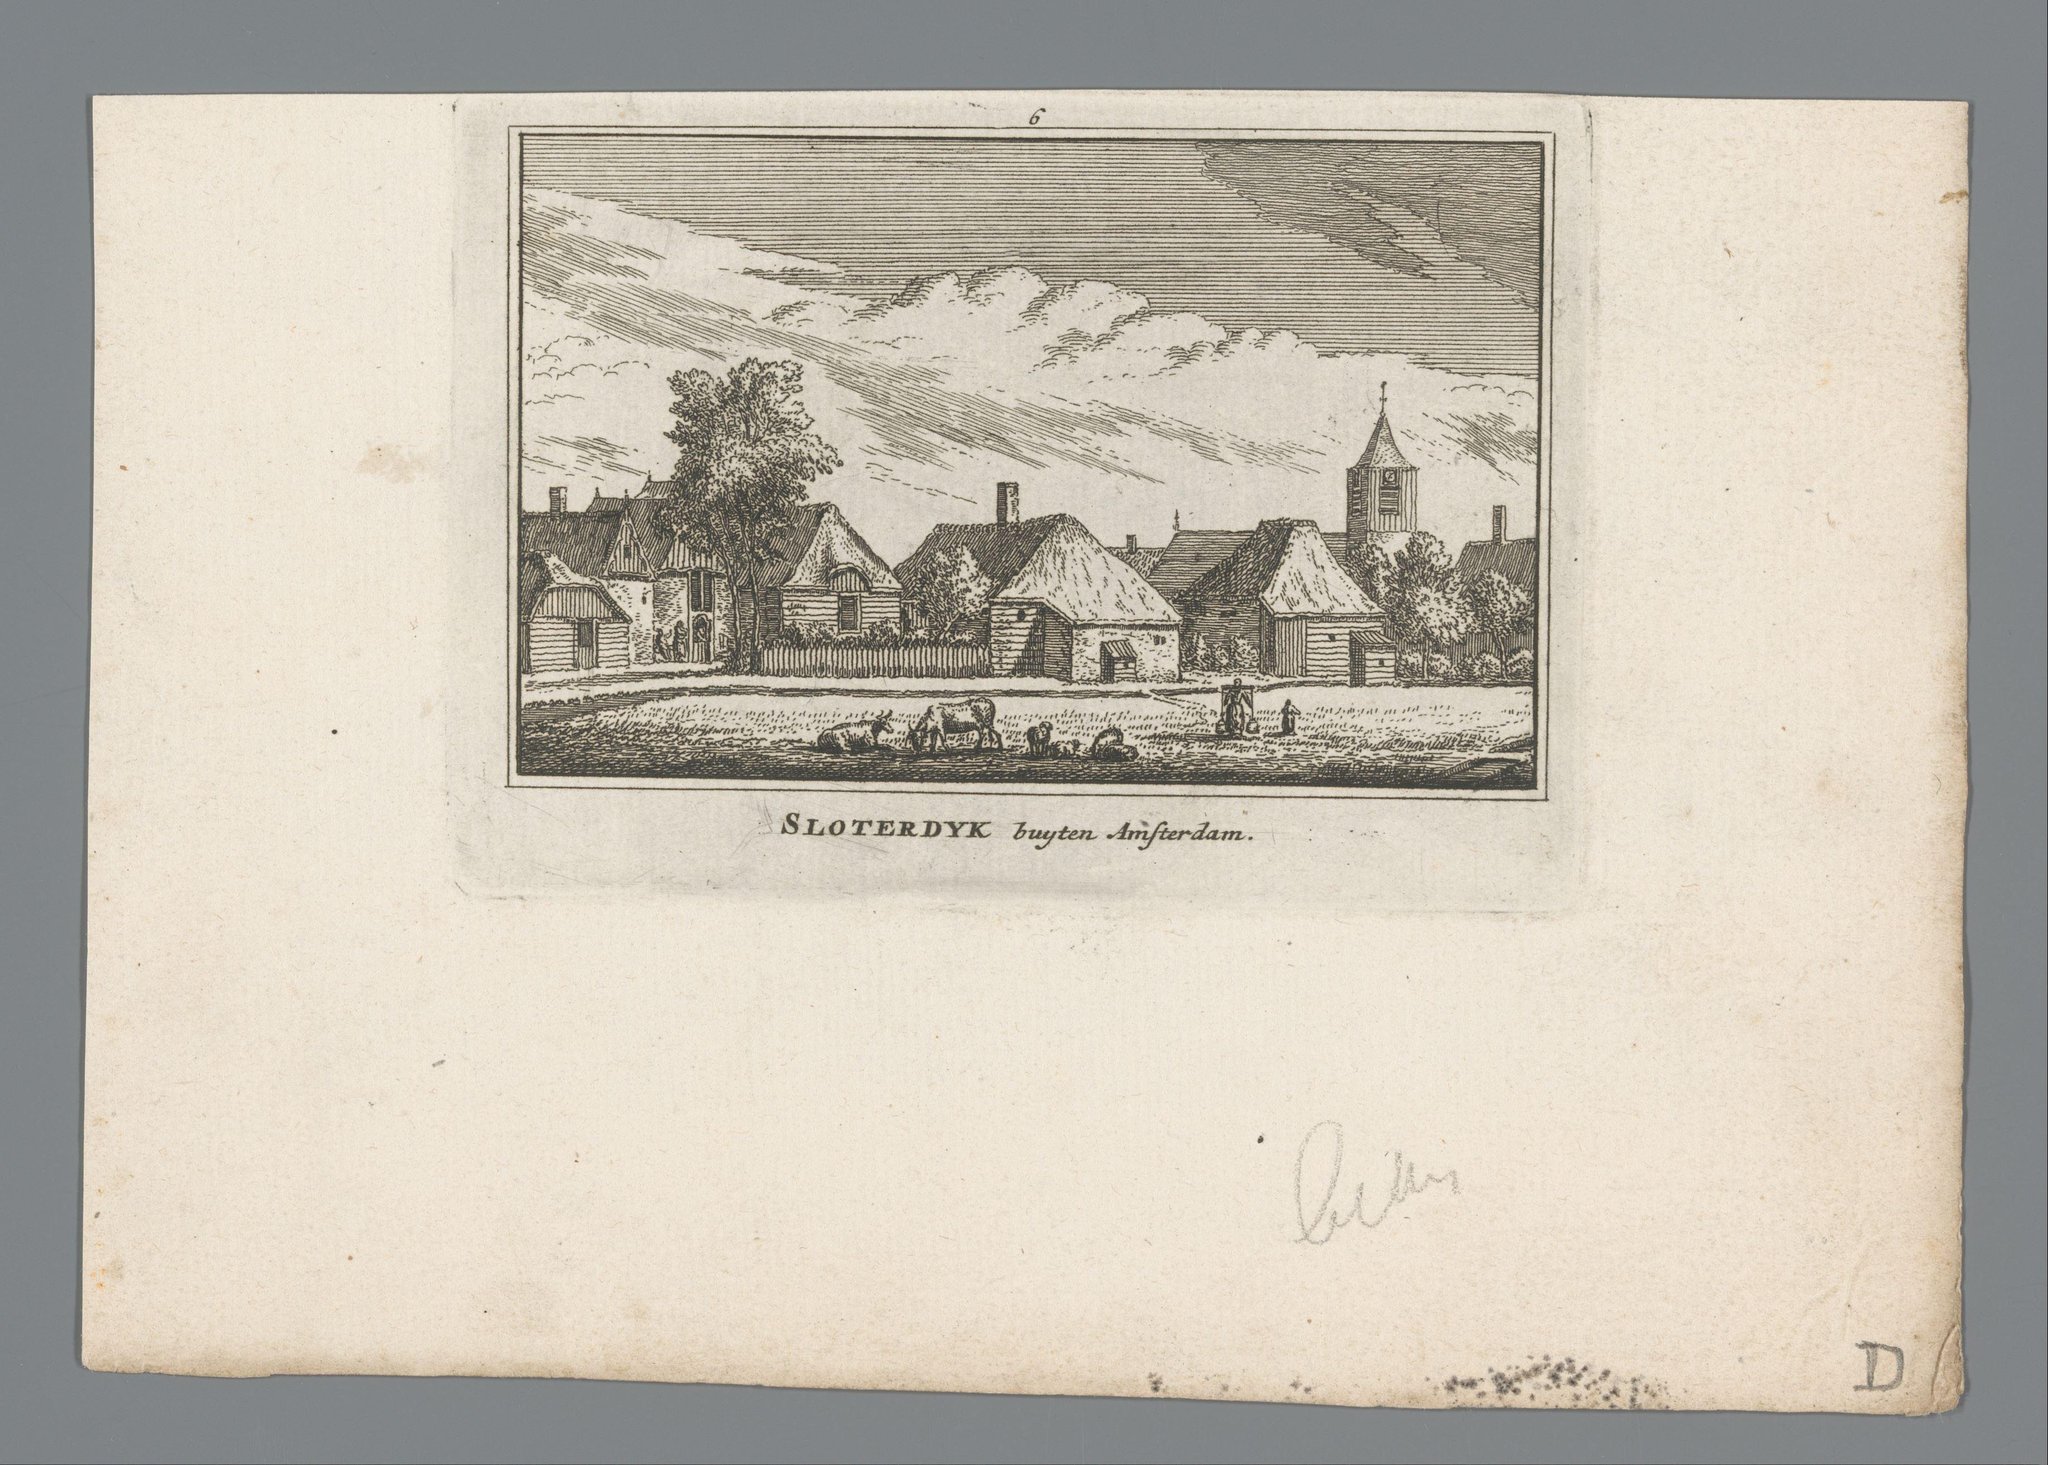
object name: print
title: Sloterdyk buyten Amsterdam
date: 1727-1733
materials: paper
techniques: etching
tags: cow, church (exterior), sheep, sloterdijk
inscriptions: collector's mark: Lugt 2228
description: Prent uit: Rademaker, Abraham, en Matthaeus Brouërius van Niedek, en Isaac Le Long. Kabinet van Nederlandsche en Kleefsche outheden en (...) voorname stads- en landgebouwen. Amsterdam: Willem Barents en Antoni Schoonenburg, 1727-1733, ill. nr. 6.